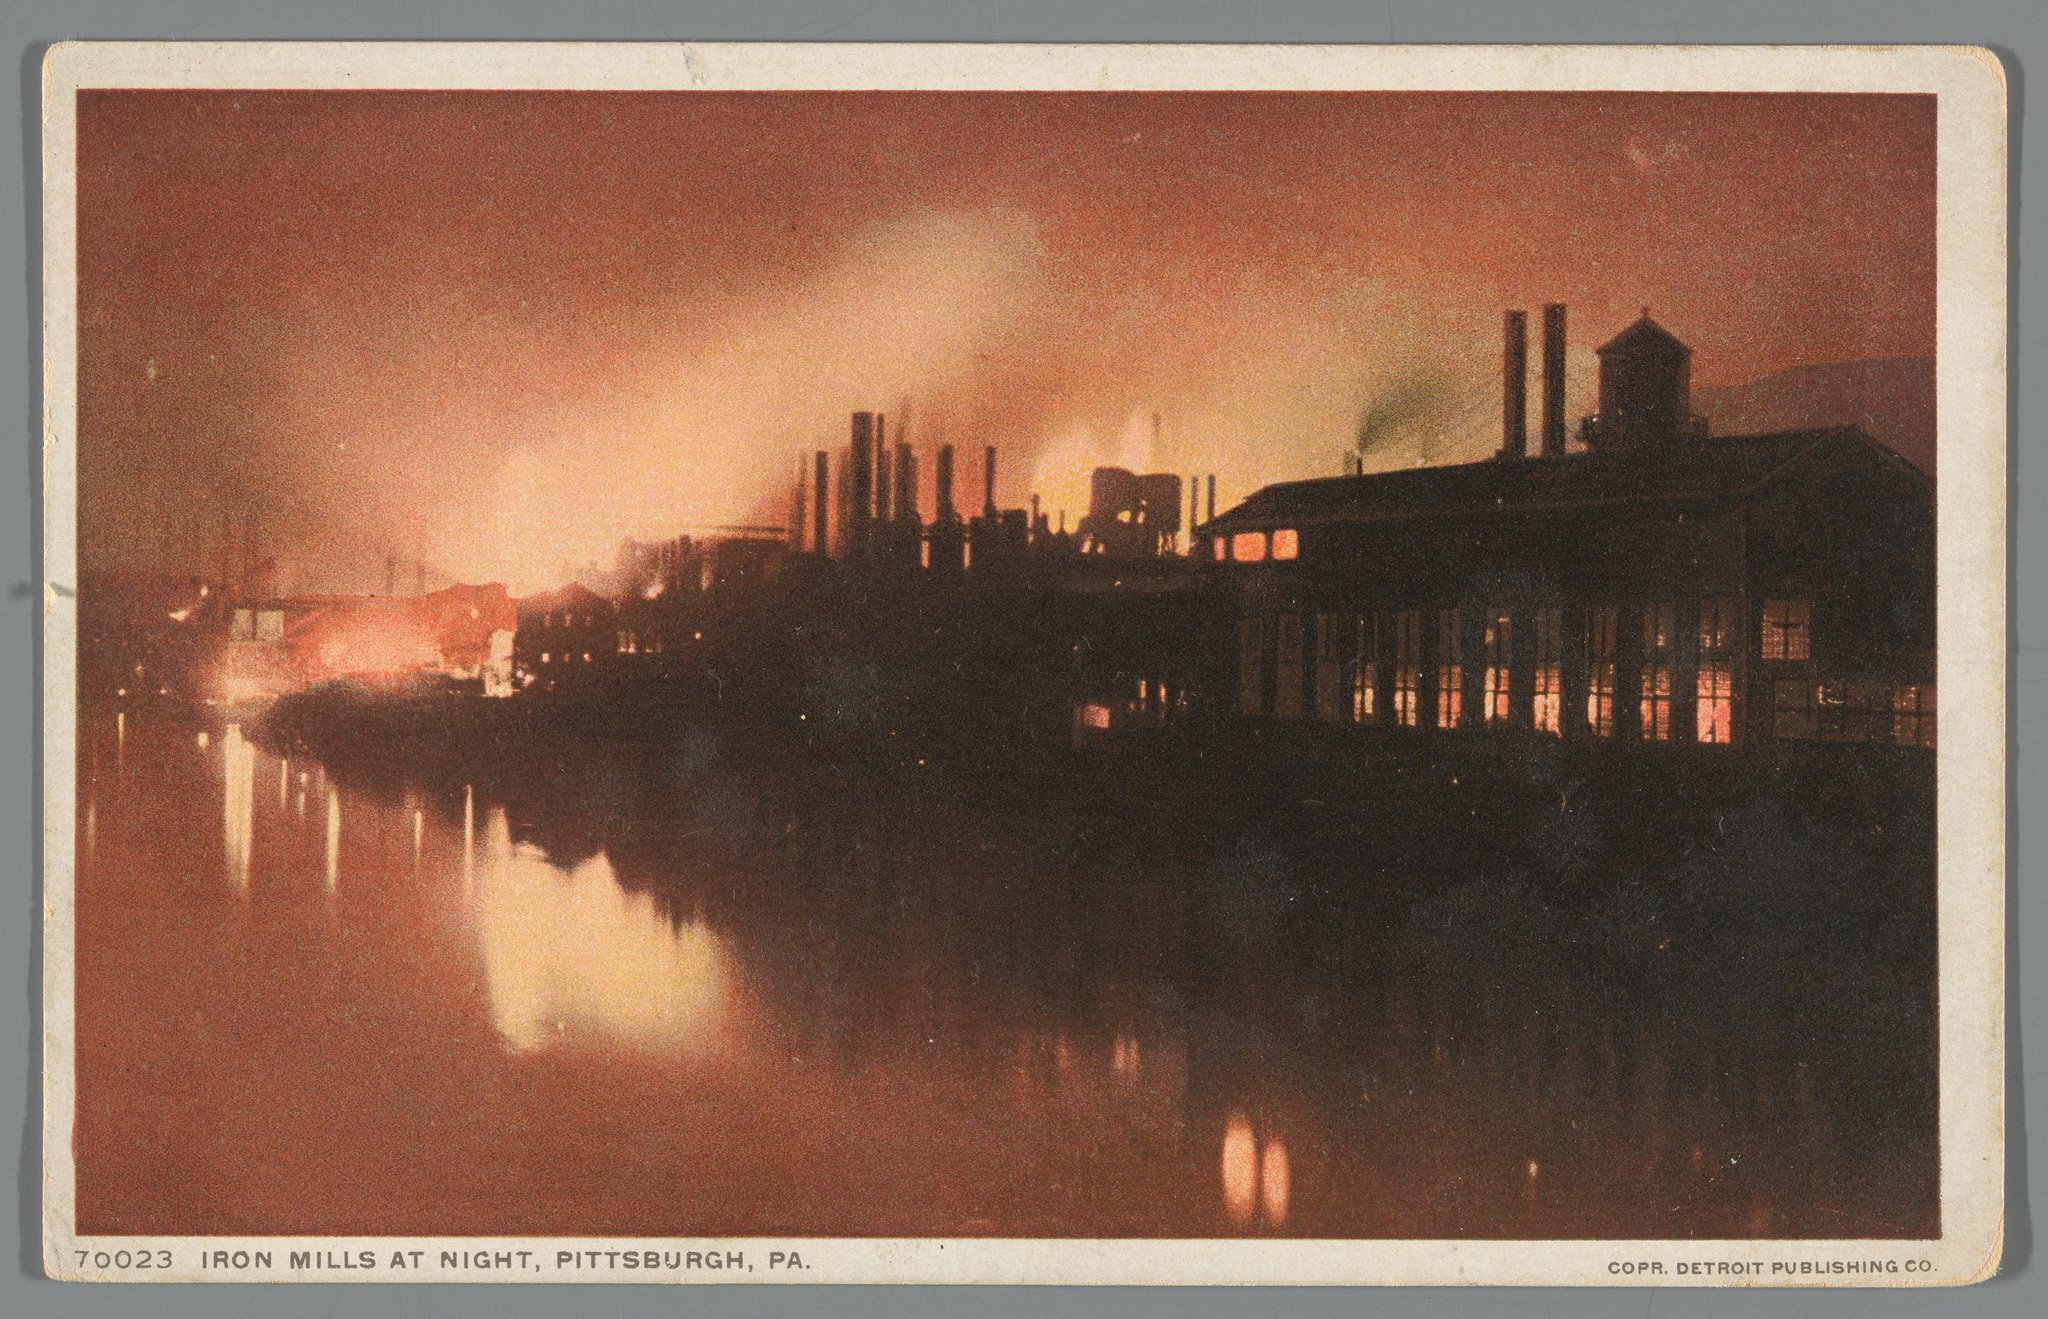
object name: ansichtkaart, prentbriefkaart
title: Gezicht op staalfabrieken in Pittsburgh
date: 1930-1960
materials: cardboard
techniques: four-color autotype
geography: united states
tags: pittsburgh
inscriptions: inscription: ‘70023 IRON MILLS AT NIGHT, PITTSBURGH, PA. / COPR. DETROIT PUBLISHING CO.’, inscription: ‘POST CARD / “PHOTOSTINT’ CARD. MADE ONLY BY DETROIT PUBLISHING CO. / TRADE MARK – REG. U.S. PAT. OFF. / […]’